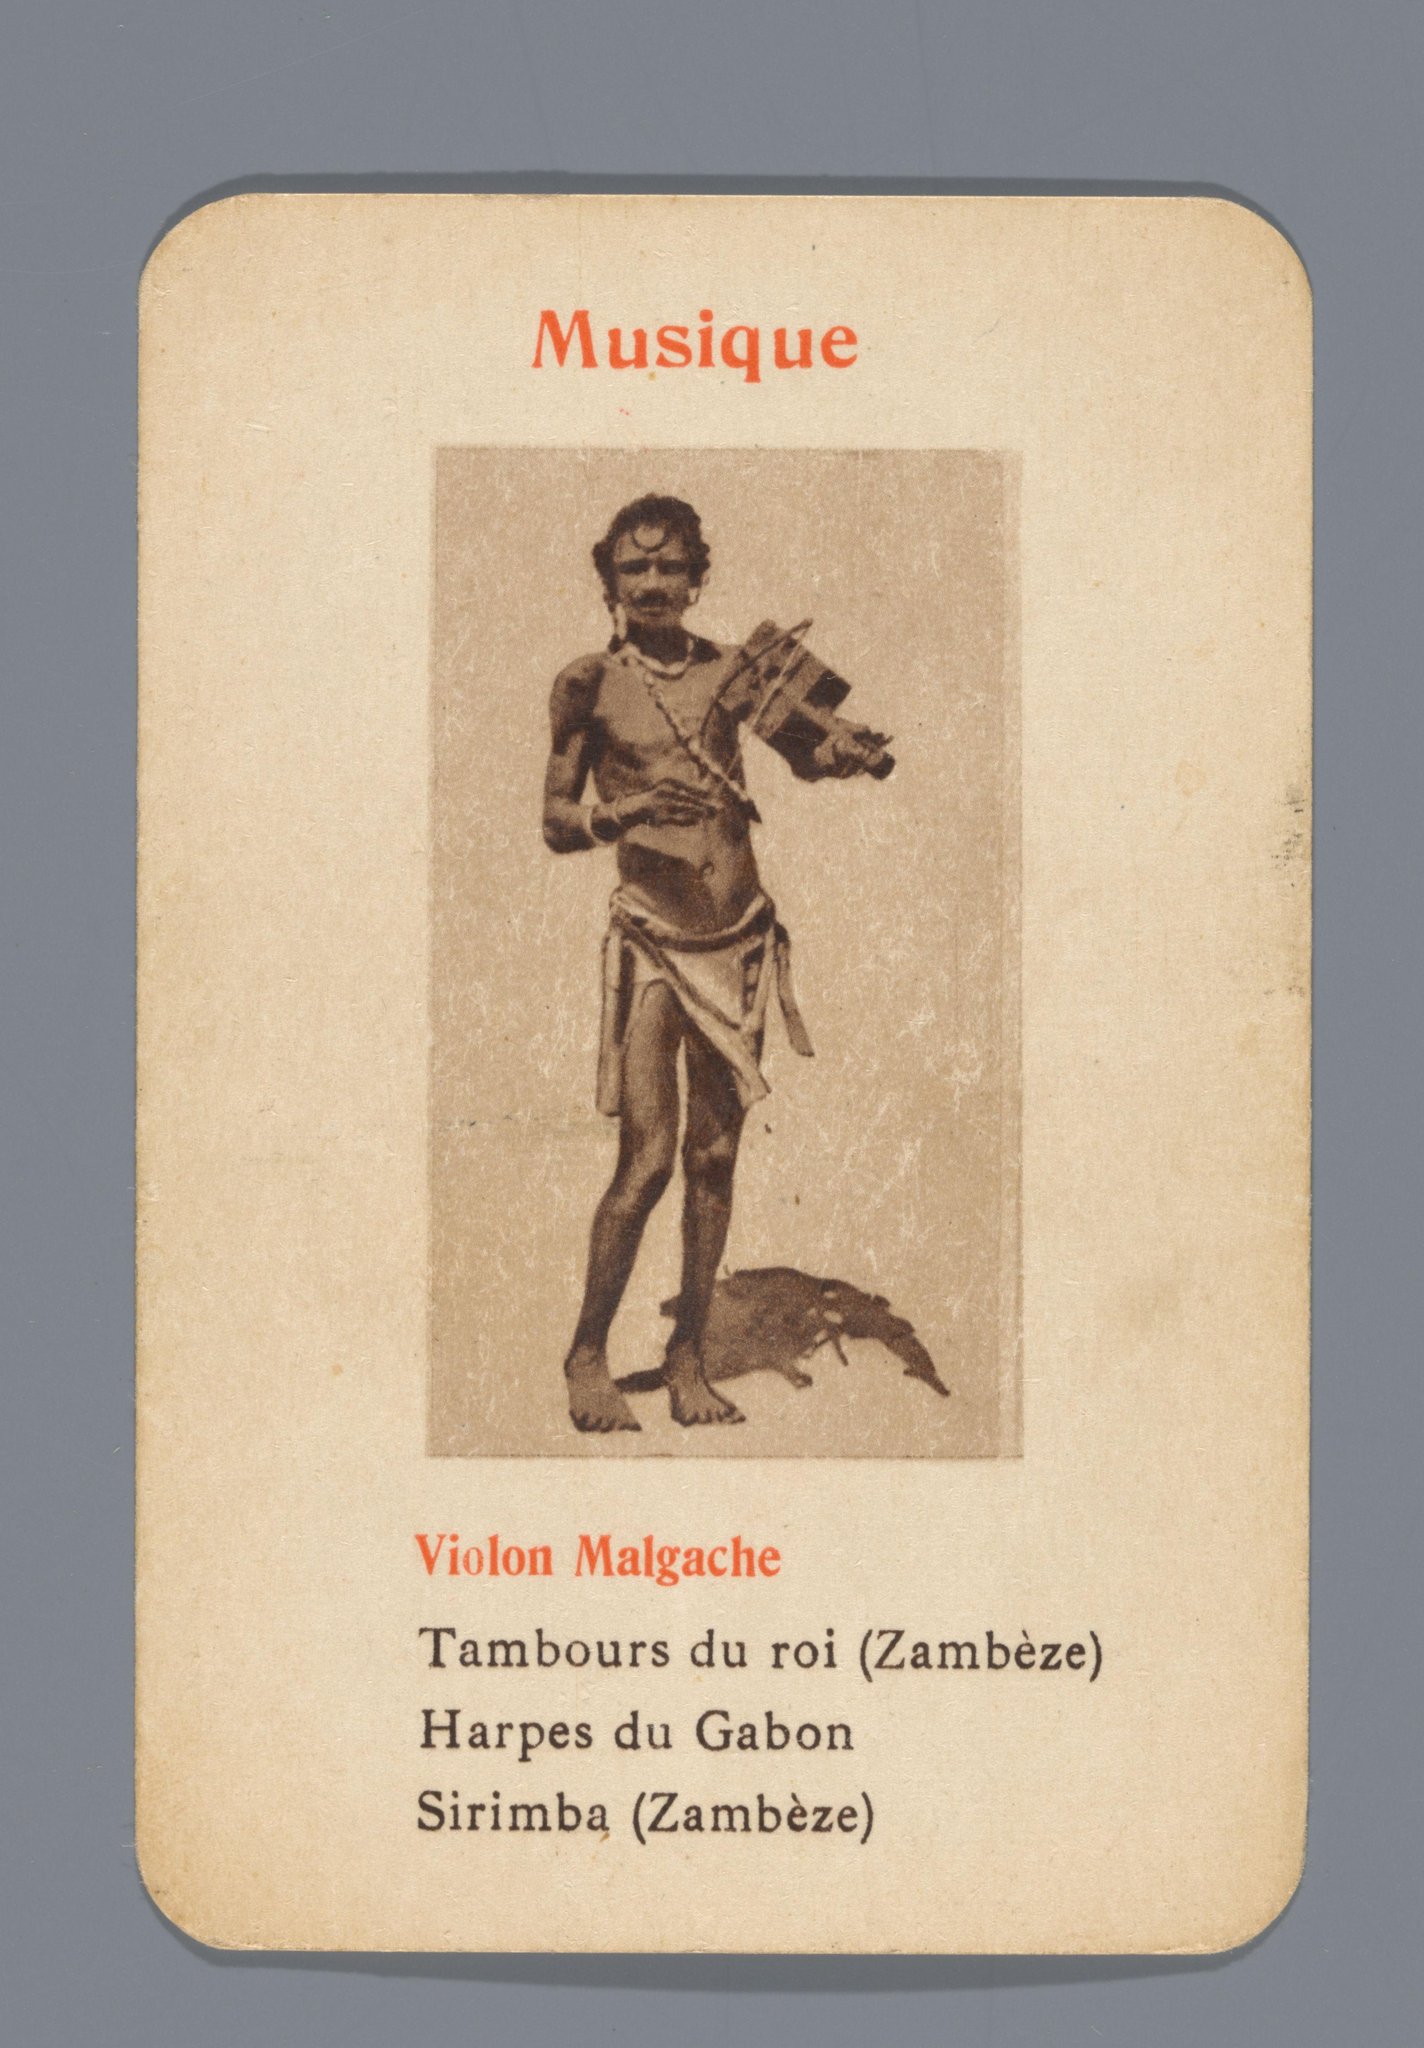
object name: card game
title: Malagassische man bespeelt een viool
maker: Anonymous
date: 1900-1920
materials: cardboard, paper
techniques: rotogravure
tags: card games, other string instruments played with bow